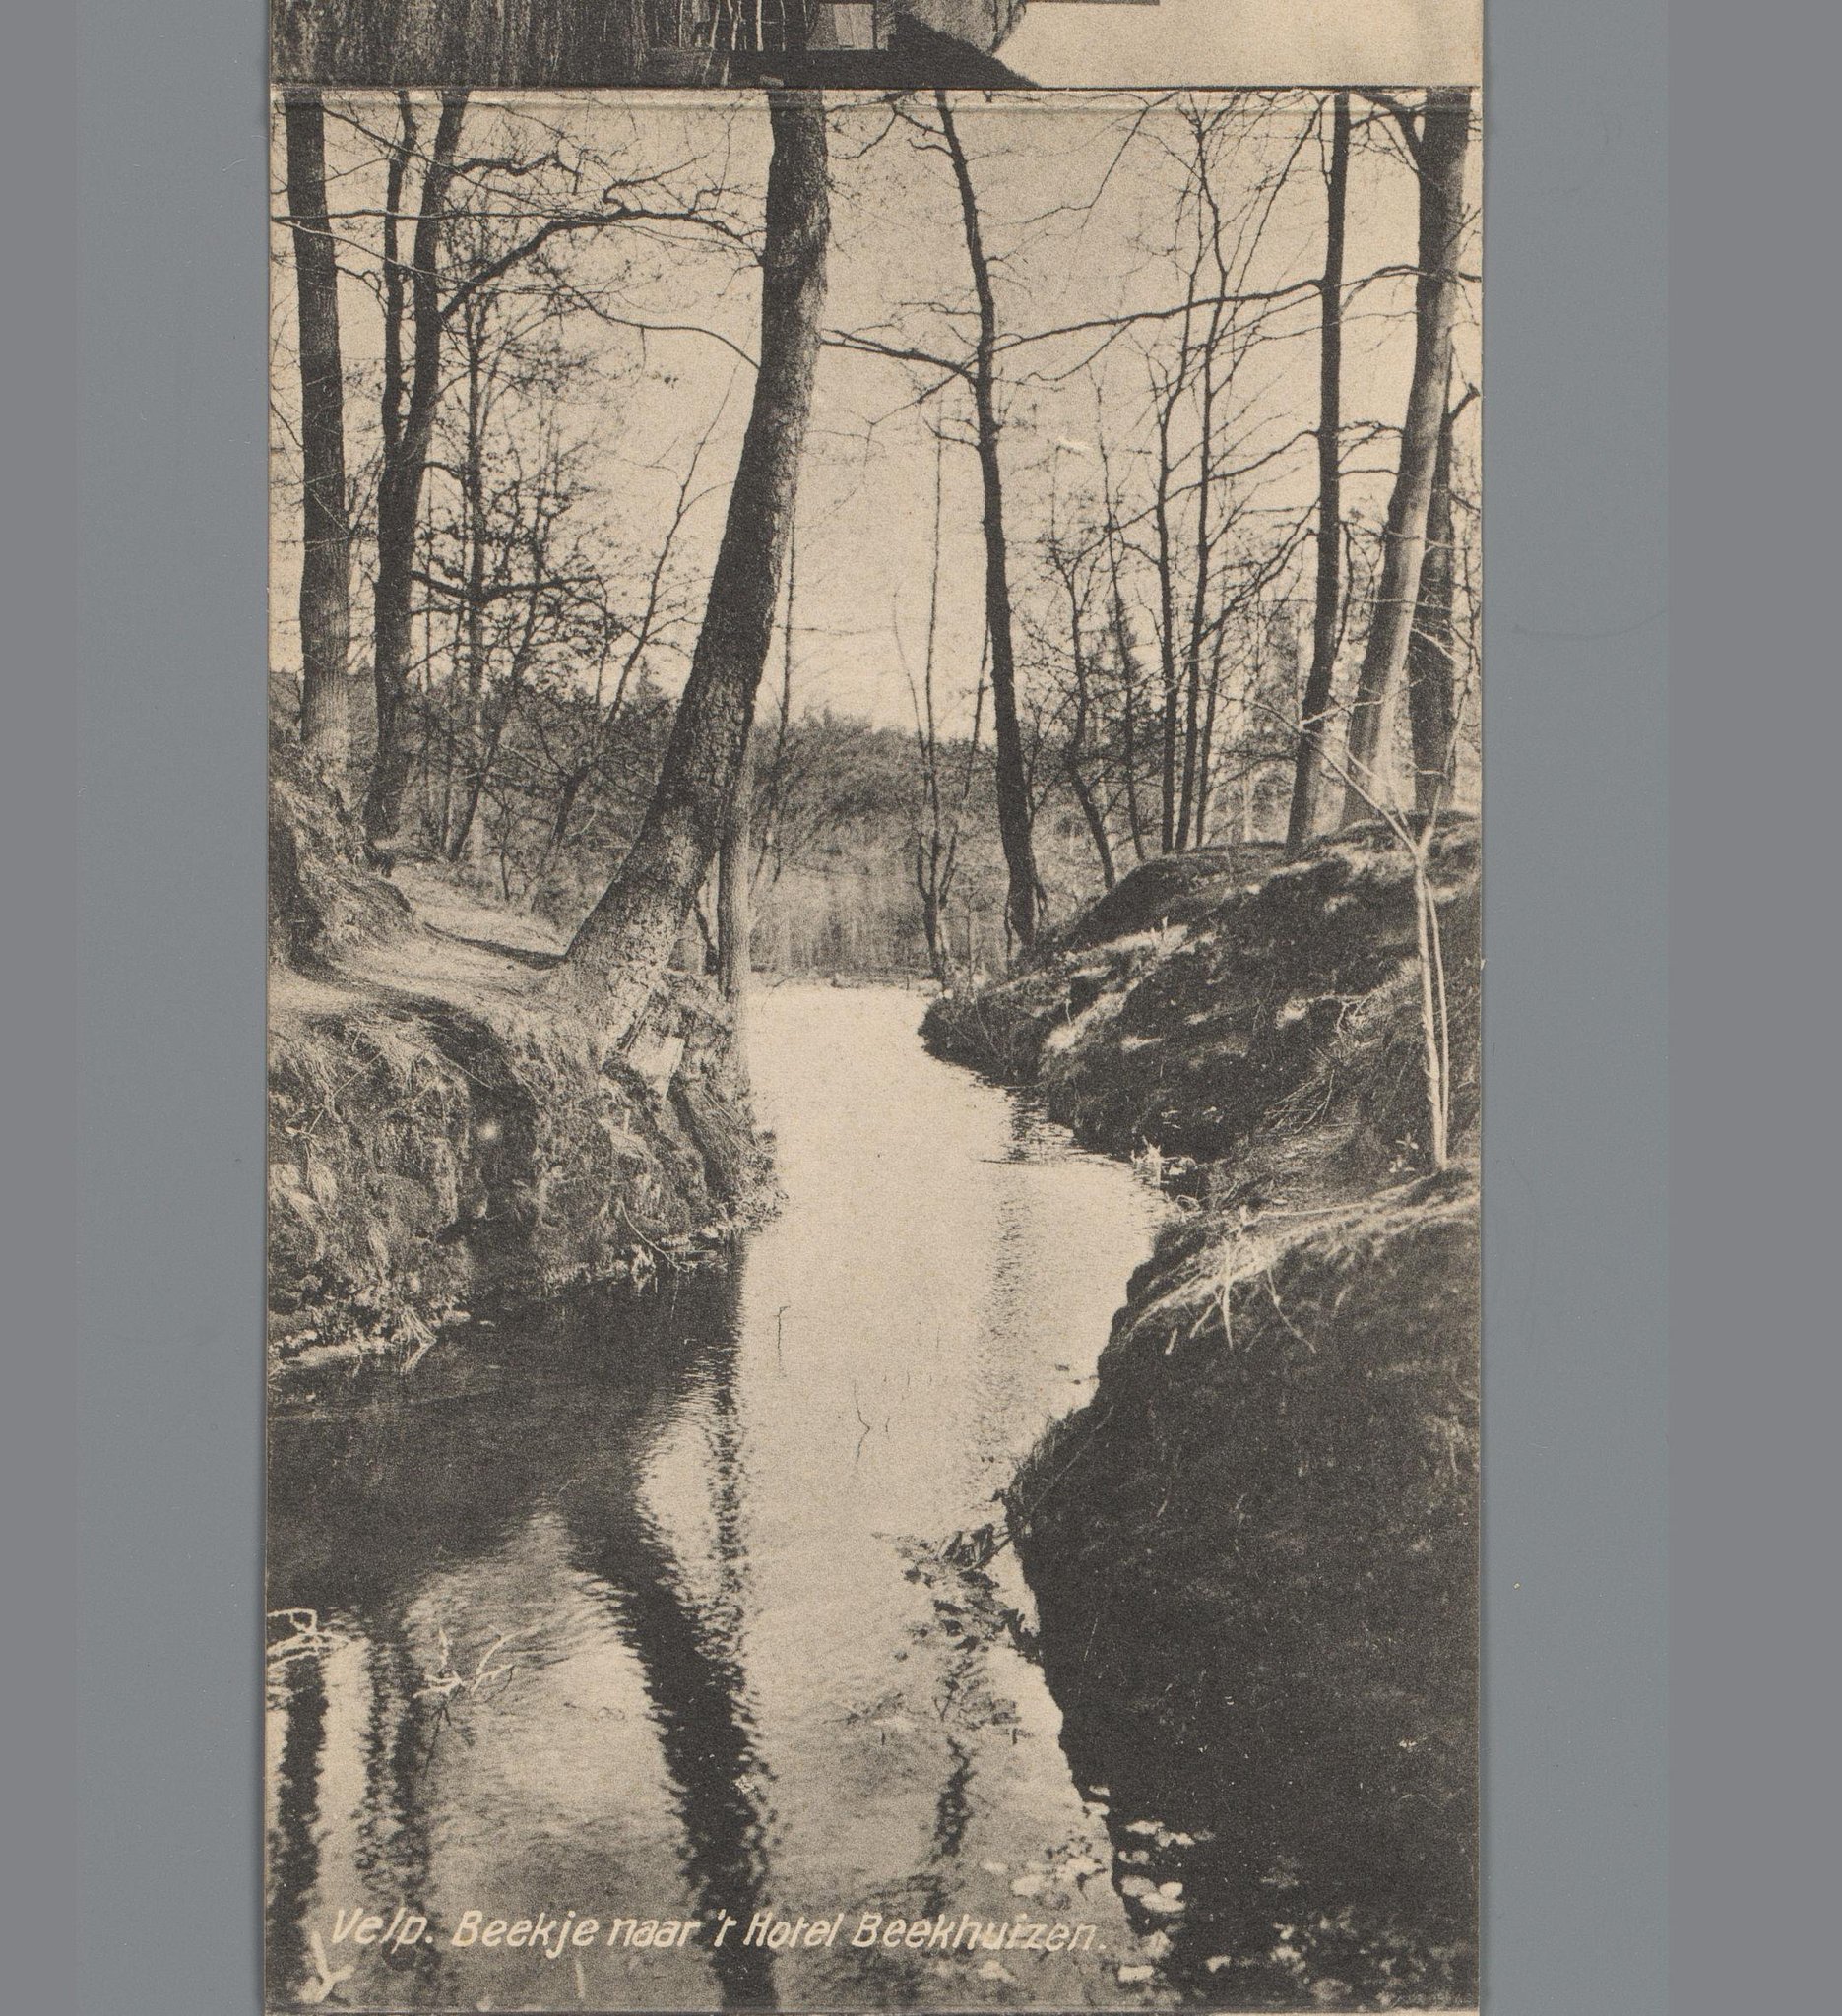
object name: ansichtkaart, prentbriefkaart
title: Velp. Beekje naar 't Hotel Beekhuizen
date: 1922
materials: cardboard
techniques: photograph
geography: velp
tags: forest, wood, brook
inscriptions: date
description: Prentbriefkaart maakt deel uit van vier kaarten die als een leporello aan elkaar vastzitten.